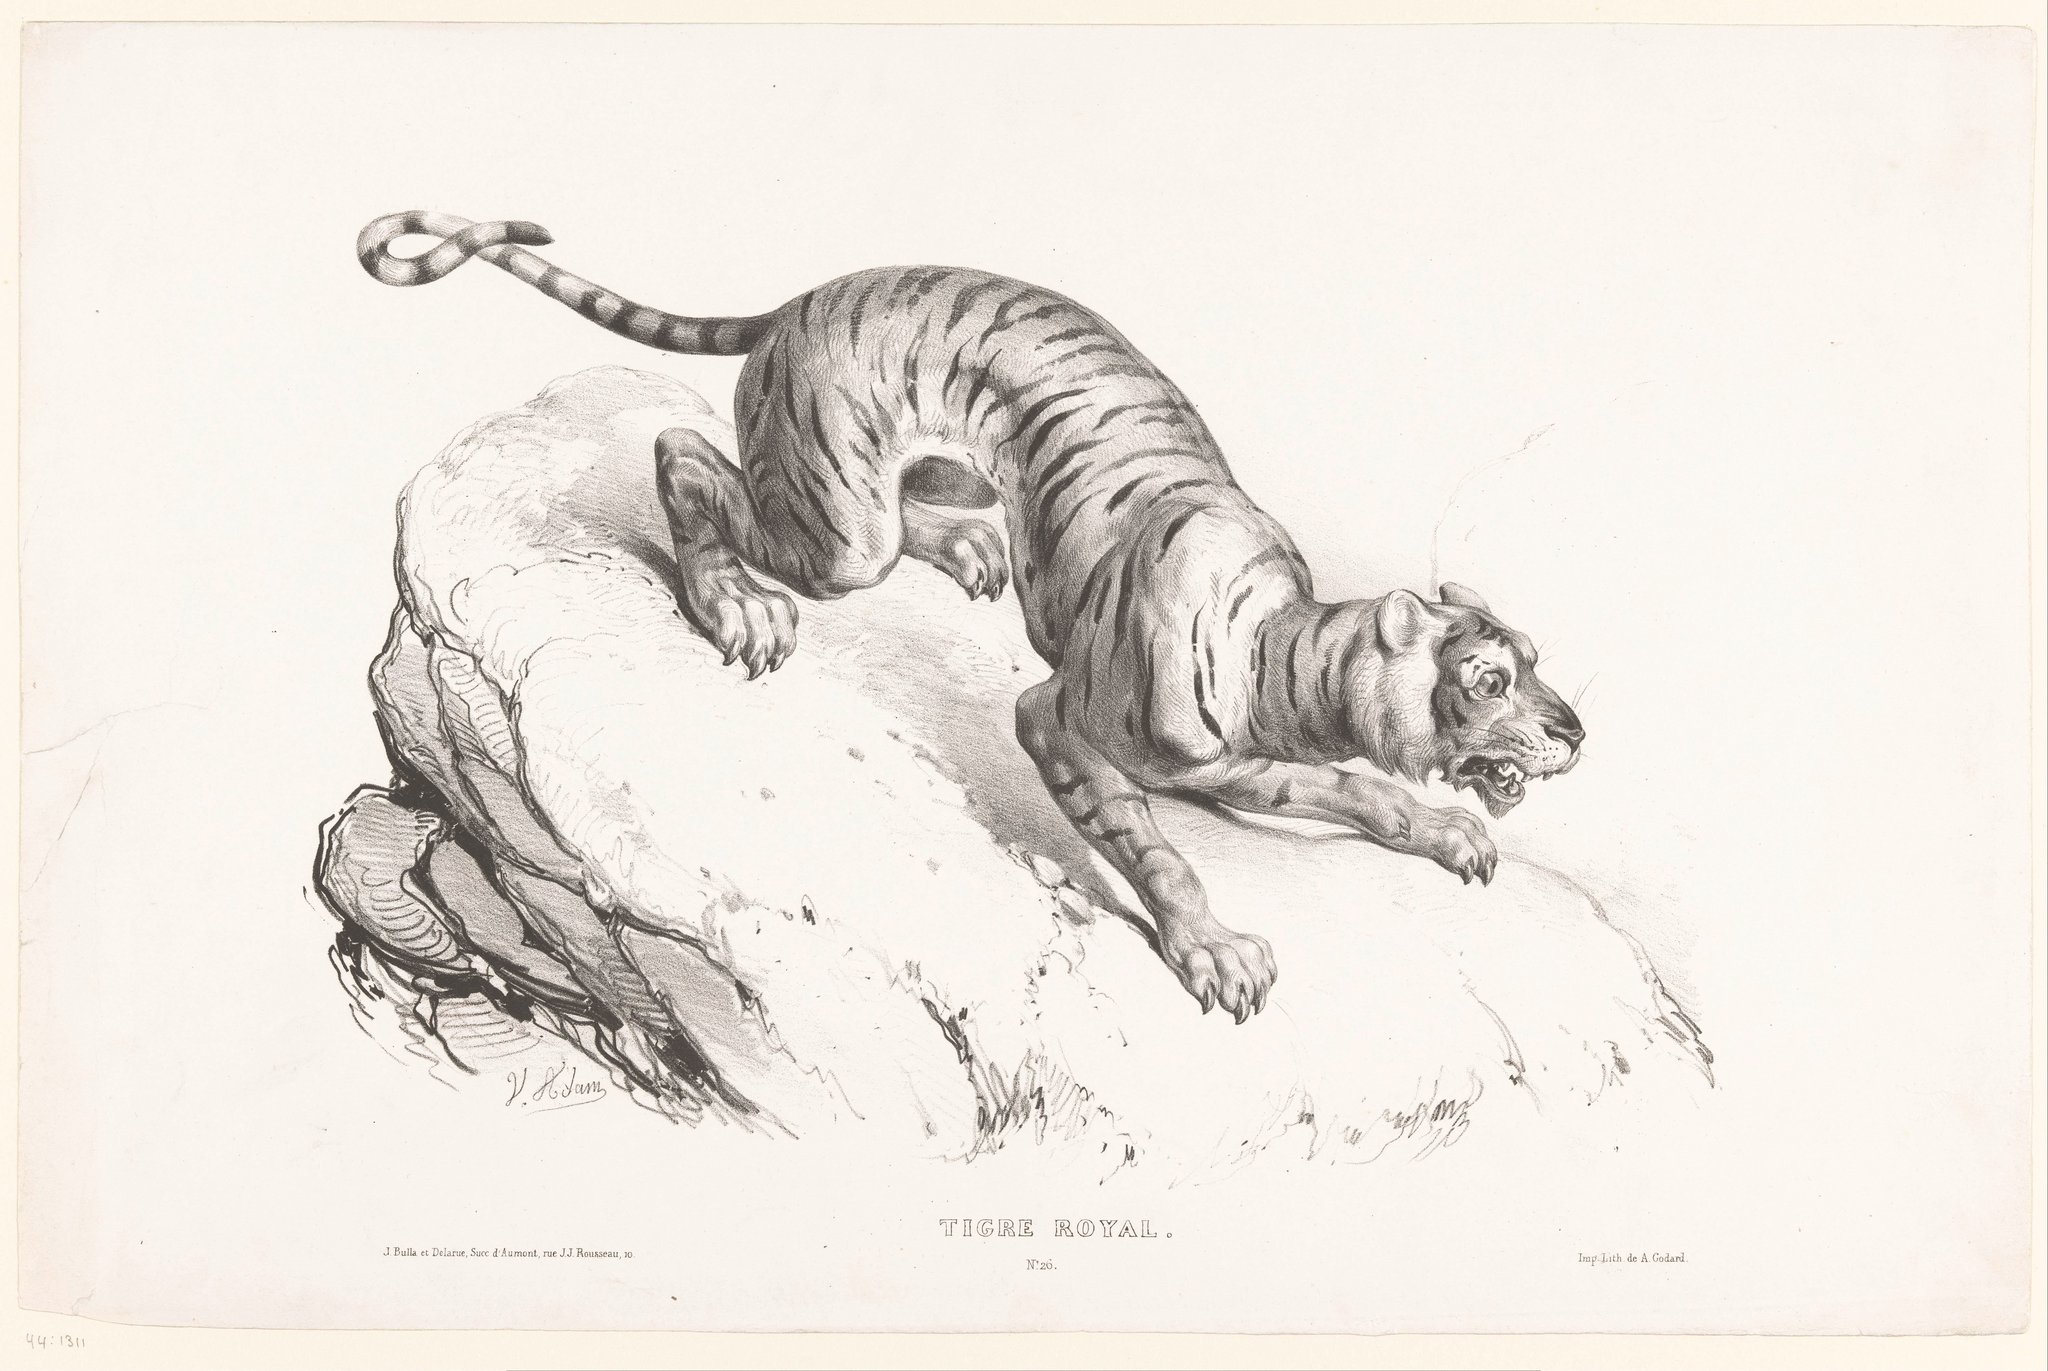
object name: print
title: Koninklijke tijger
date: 1843-1844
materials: paper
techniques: lithograph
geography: paris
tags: beasts of prey, predatory animals: tiger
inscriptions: collector's mark: Lugt 2228